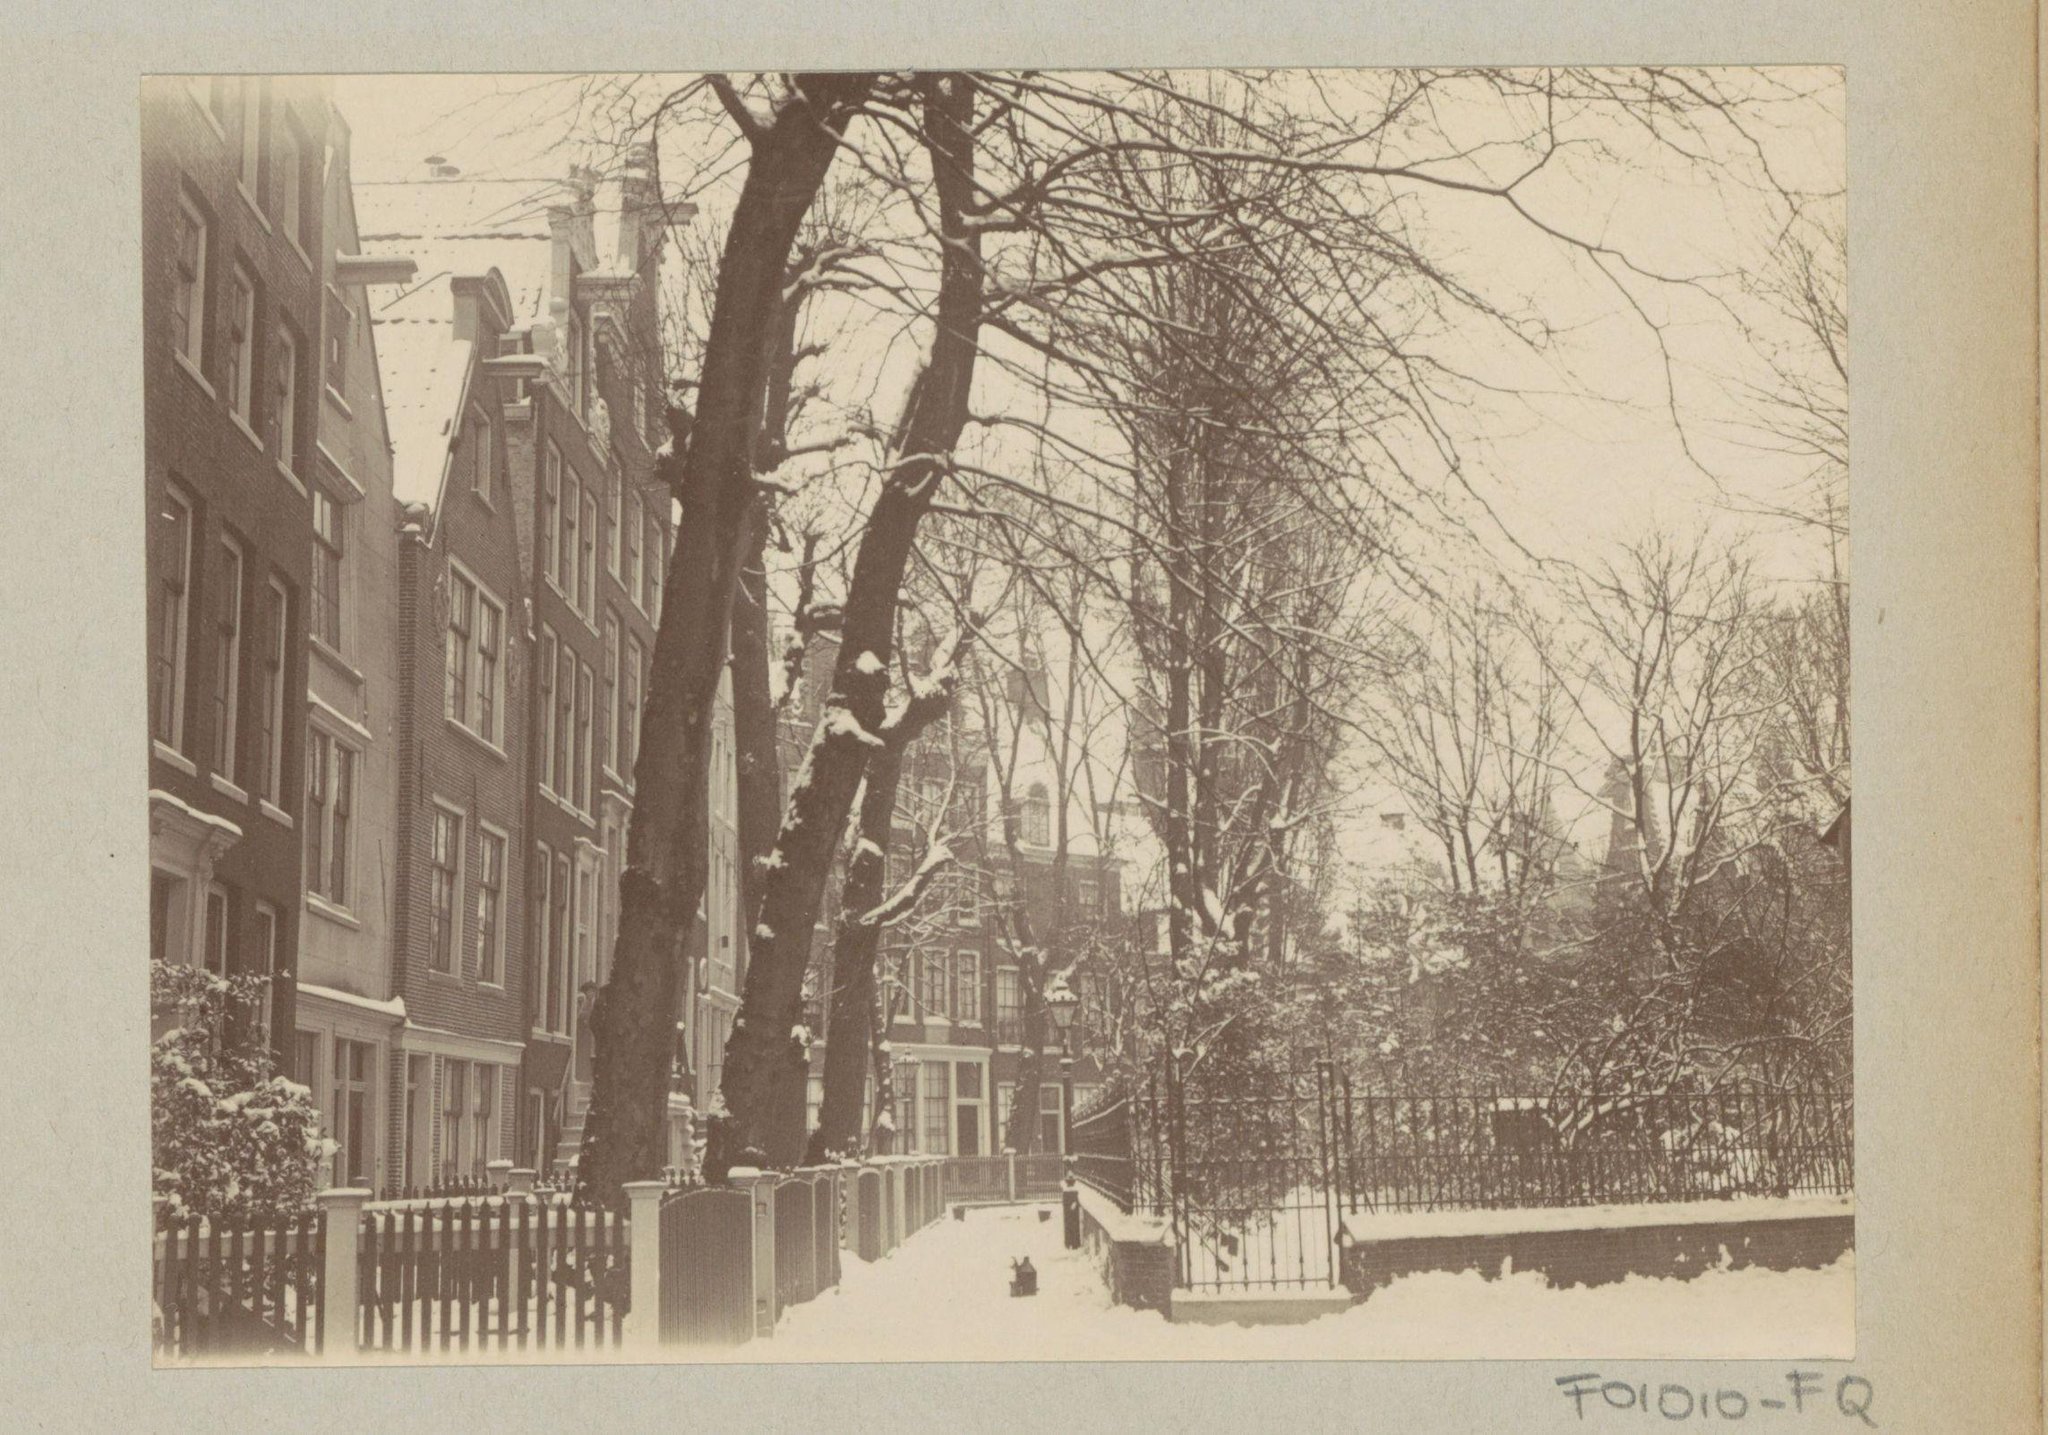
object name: photograph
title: Huizen aan het Begijnhof in Amsterdam in de sneeuw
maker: Anonymous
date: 1900-1910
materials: photographic support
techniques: daylight paper print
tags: alms-house (dutch: 'hofje'), winter landscape; landscape symbolizing winter (the four seasons of the year), snow, façade (of house or building)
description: Onderdeel van Familiealbum met onder meer foto's van Wijnhandel Kraaij & Co. Bordeaux-Amsterdam.